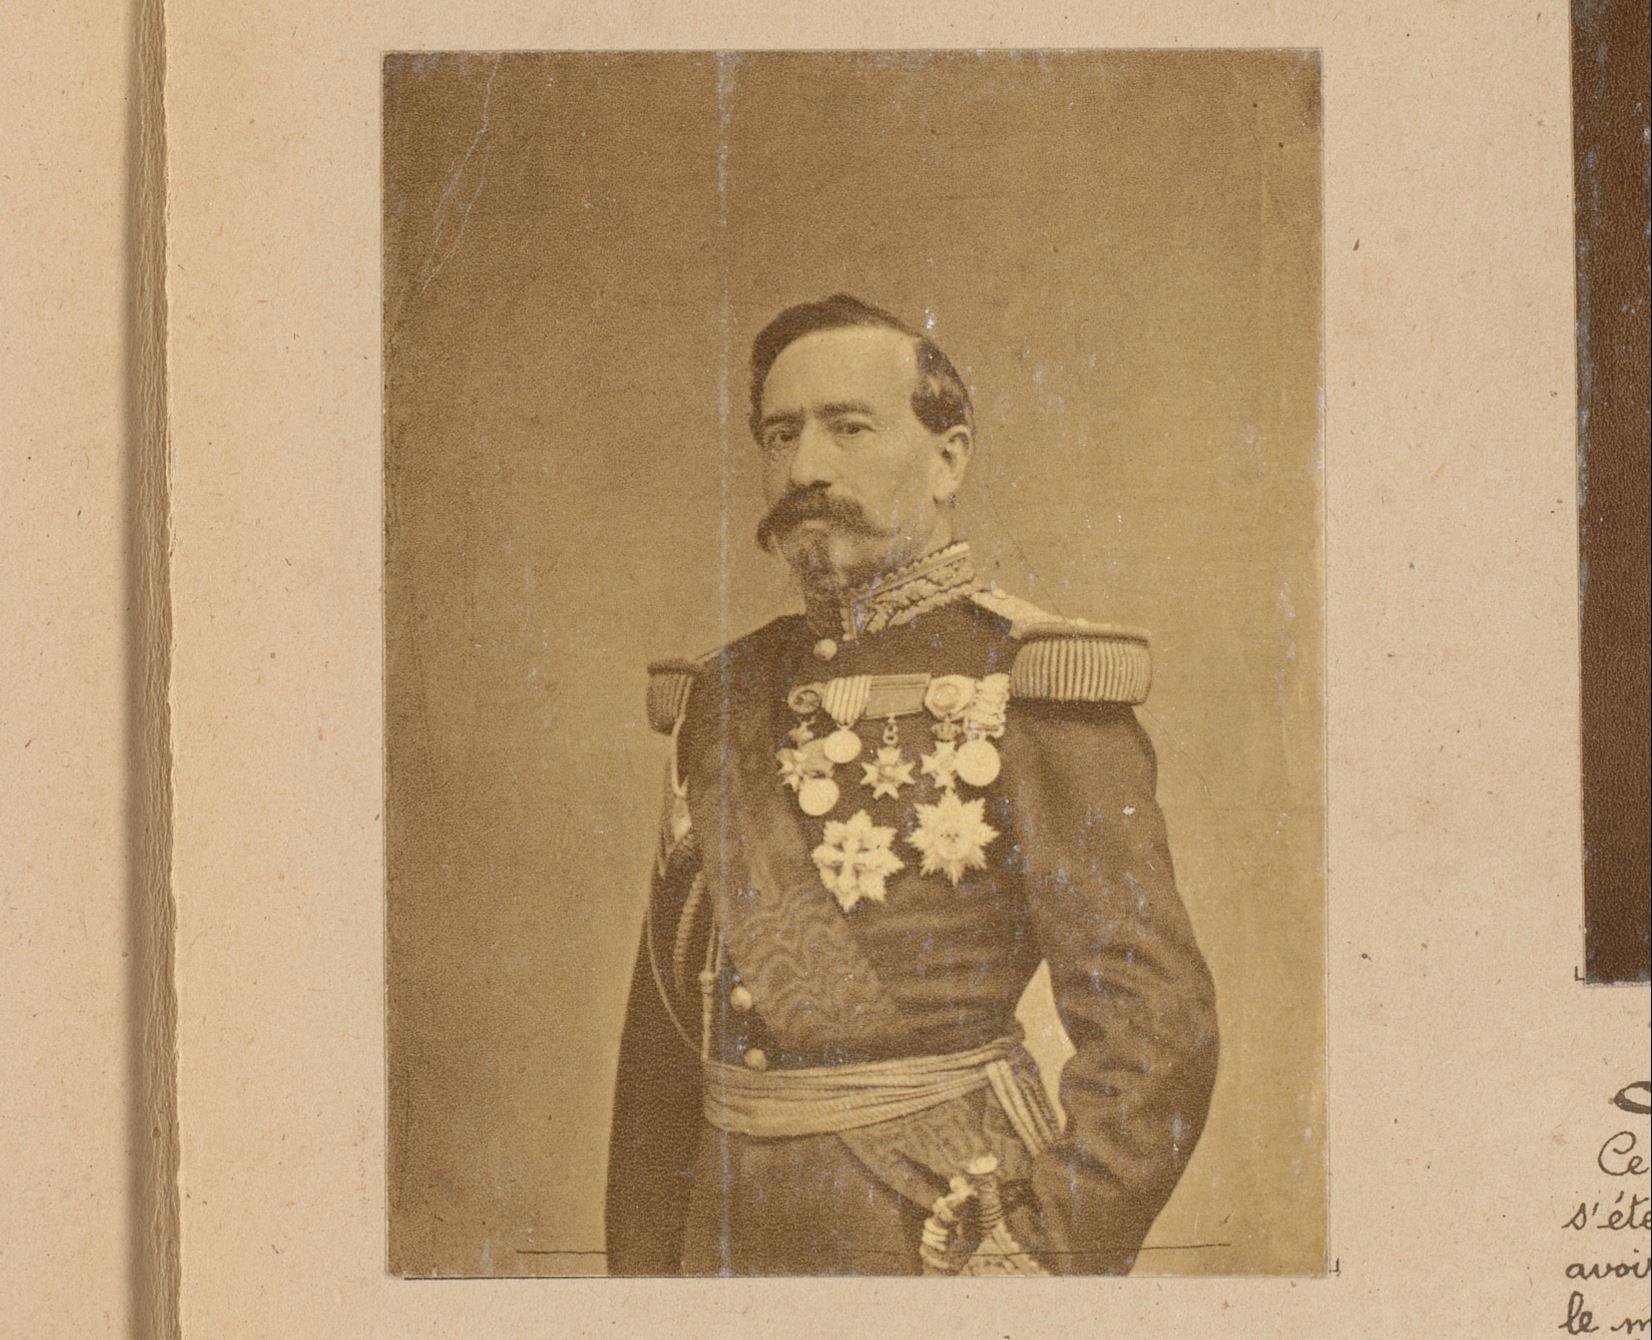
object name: photograph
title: Général Bourbaki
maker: Anonymous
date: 1868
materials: paper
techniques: rotogravure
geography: france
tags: commander-in-chief, general, marshal, historical persons, france